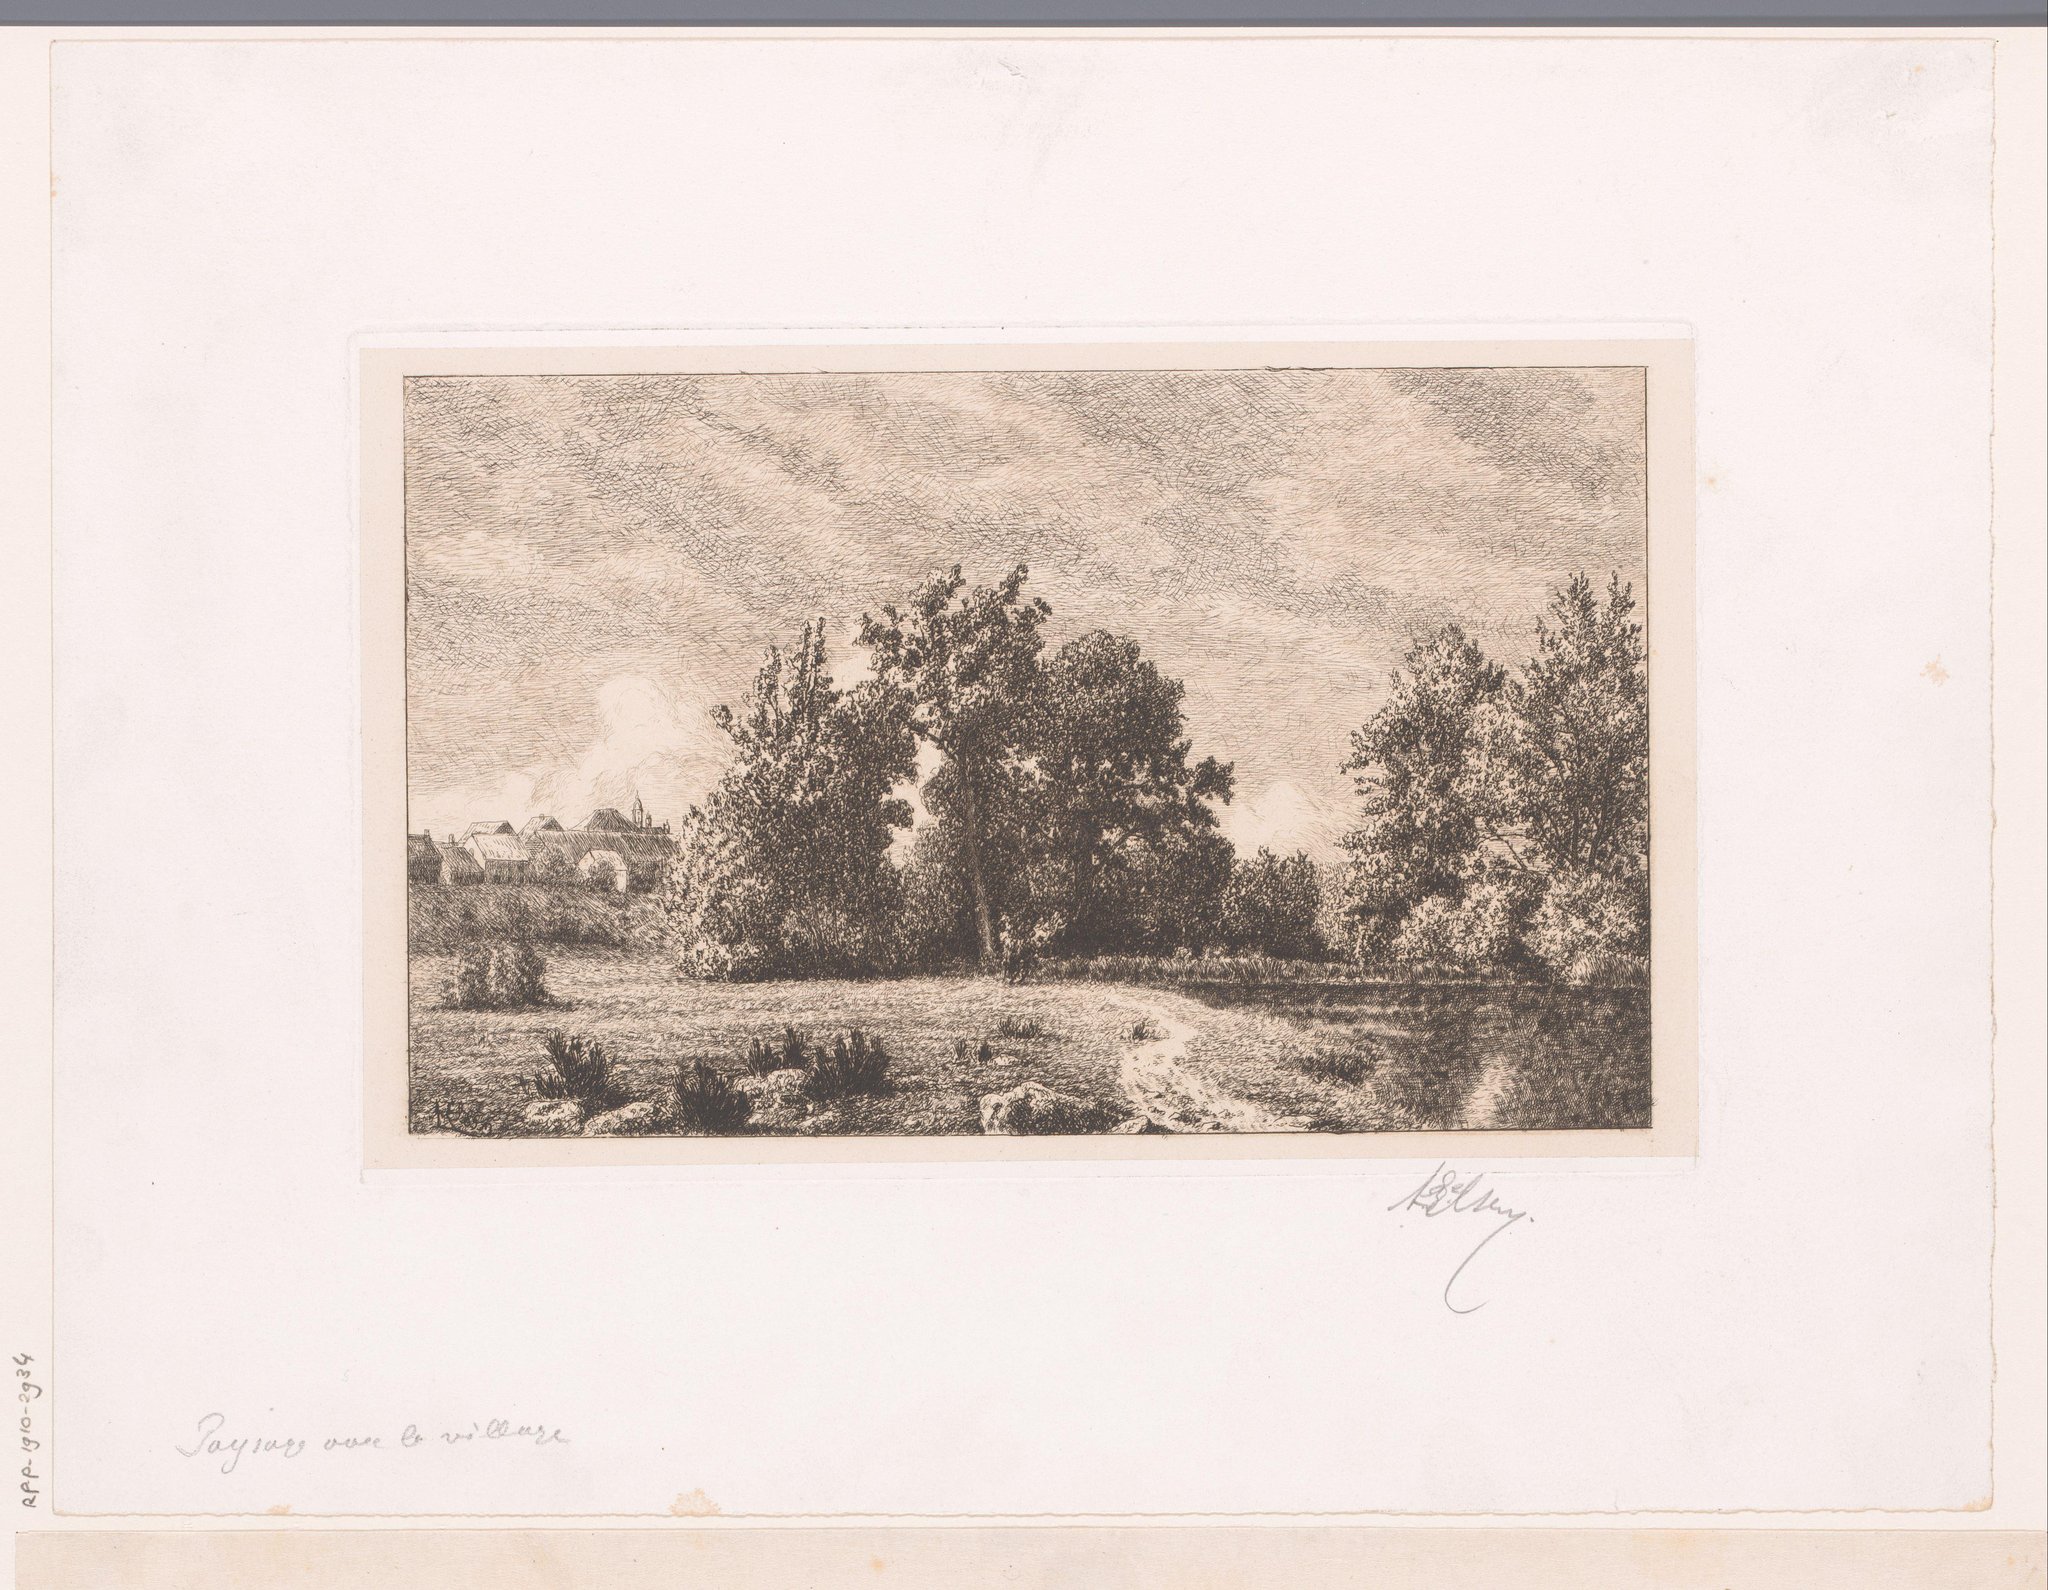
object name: print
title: Landschap met waterplas en een dorp op de achtergrond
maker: alfred elsen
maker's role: painter, print maker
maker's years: 1850-1914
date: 1860-1910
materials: paper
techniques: etching, intaglio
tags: prospect of village, silhouette of village, lake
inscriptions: collector's mark: Lugt 2228